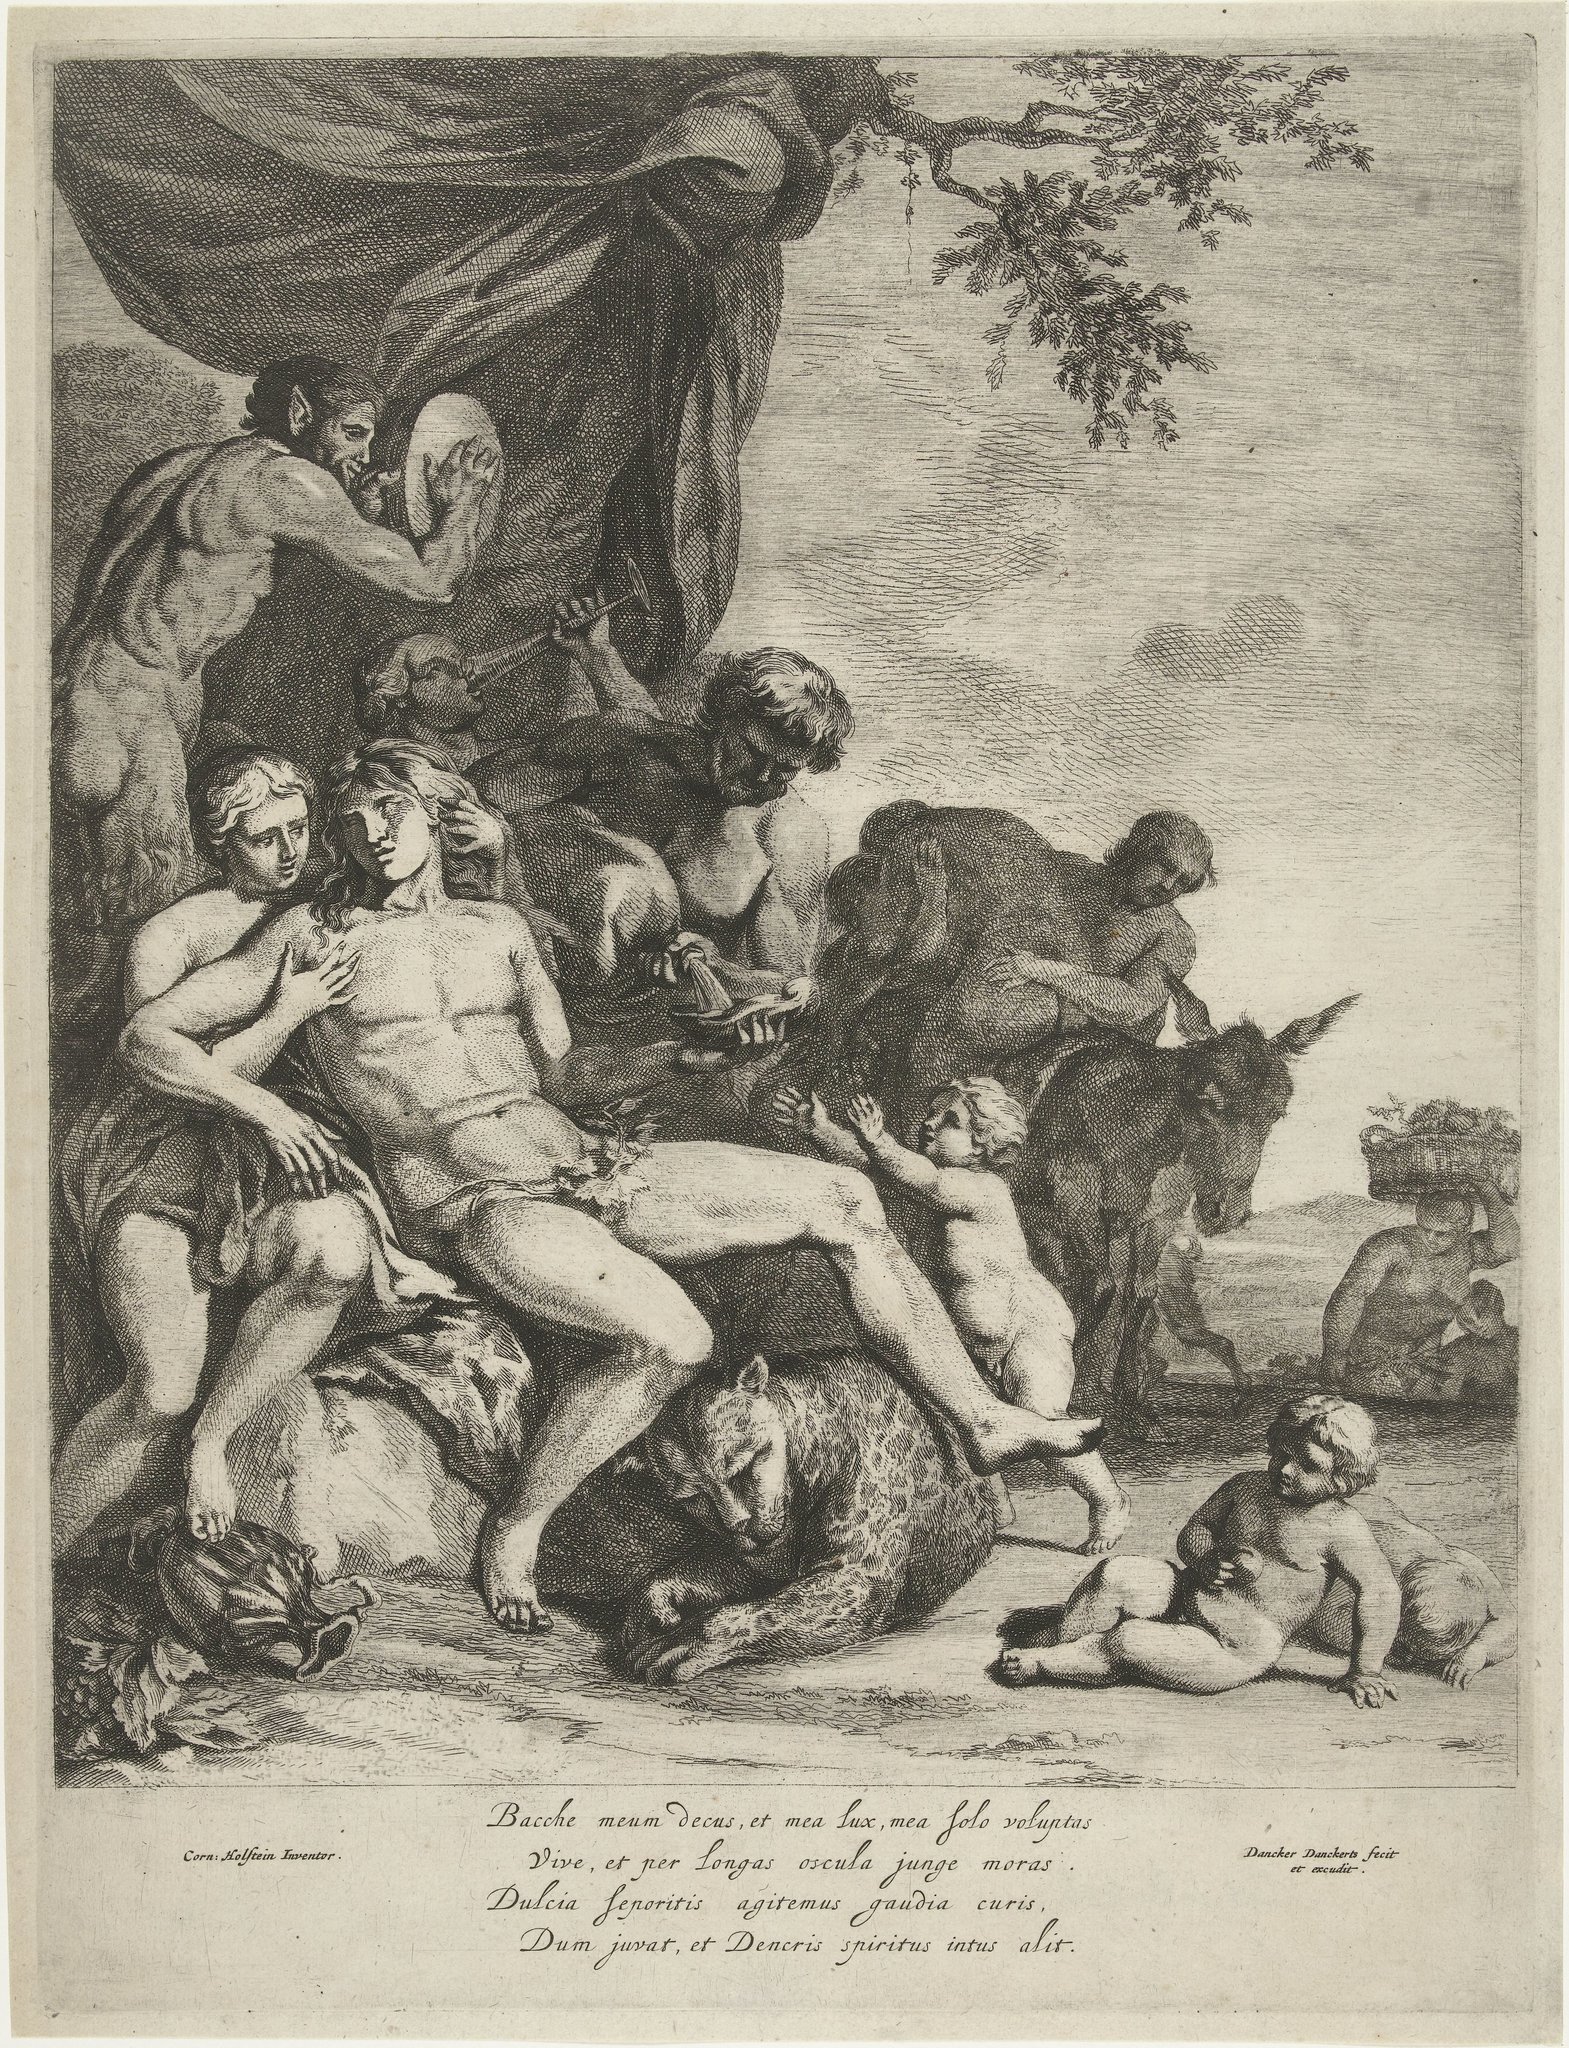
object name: print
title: Bacchanaal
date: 1633-1666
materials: paper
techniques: etching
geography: amsterdam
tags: bacchanal: bacchus with his wine-flushed train (thiasos)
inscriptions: collector's mark: Lugt 2228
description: Bacchanaal waarbij de wijn rijkelijk vloeit en een sater op een tamboerijn speelt. De dronken Bacchus wordt door twee mannen van een ezel getild. In ondermarge Latijns vers in vier regels.